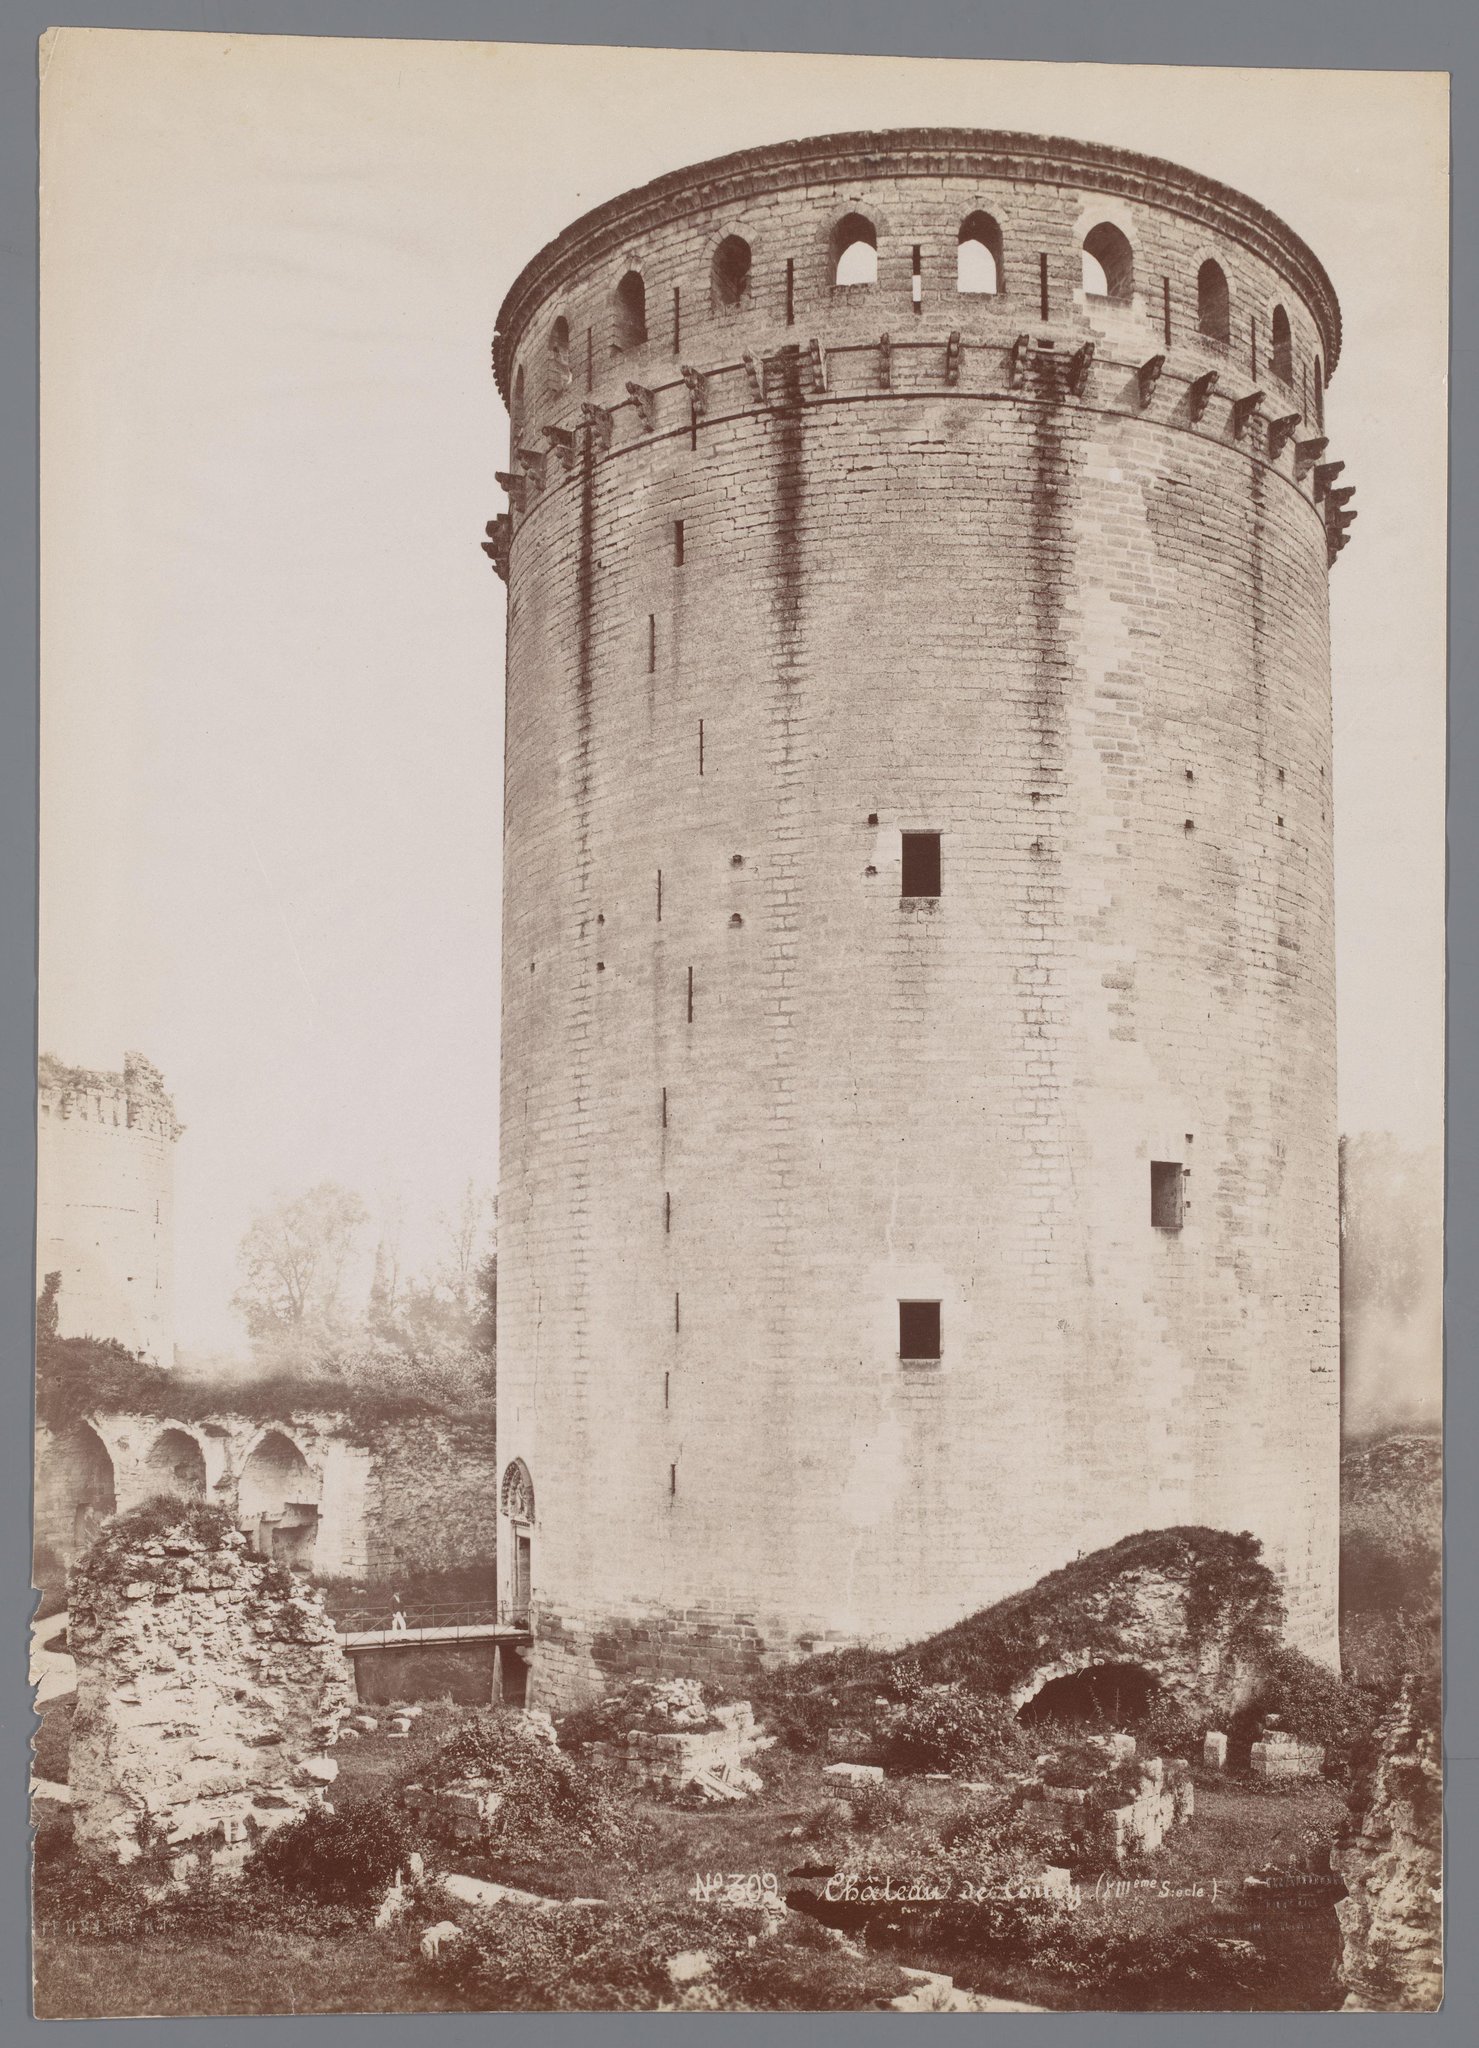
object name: photograph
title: Gezicht op Château de Coucy, Frankrijk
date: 1870-1890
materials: paper, photographic support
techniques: albumen print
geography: france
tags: coucy-le-château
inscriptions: annotation: ‘No. 309. Château de Coucy (XIIIeme Siecle)’, check stamp: ‘[M]IEUSEMENT//PHOTOGRAPHE’, check stamp: ‘A. GIRAUDON//ÉDITEUR//15 R. BONAPARTE, PARIS’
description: Foto vanuit kikvorsperspectief op de ronde toren van Château de Coucy, met struiken aan de voet en een deel van de ruïne van het kasteel ernaast. Tevens een ophaalbrug met daarop een man met hoge hoed.